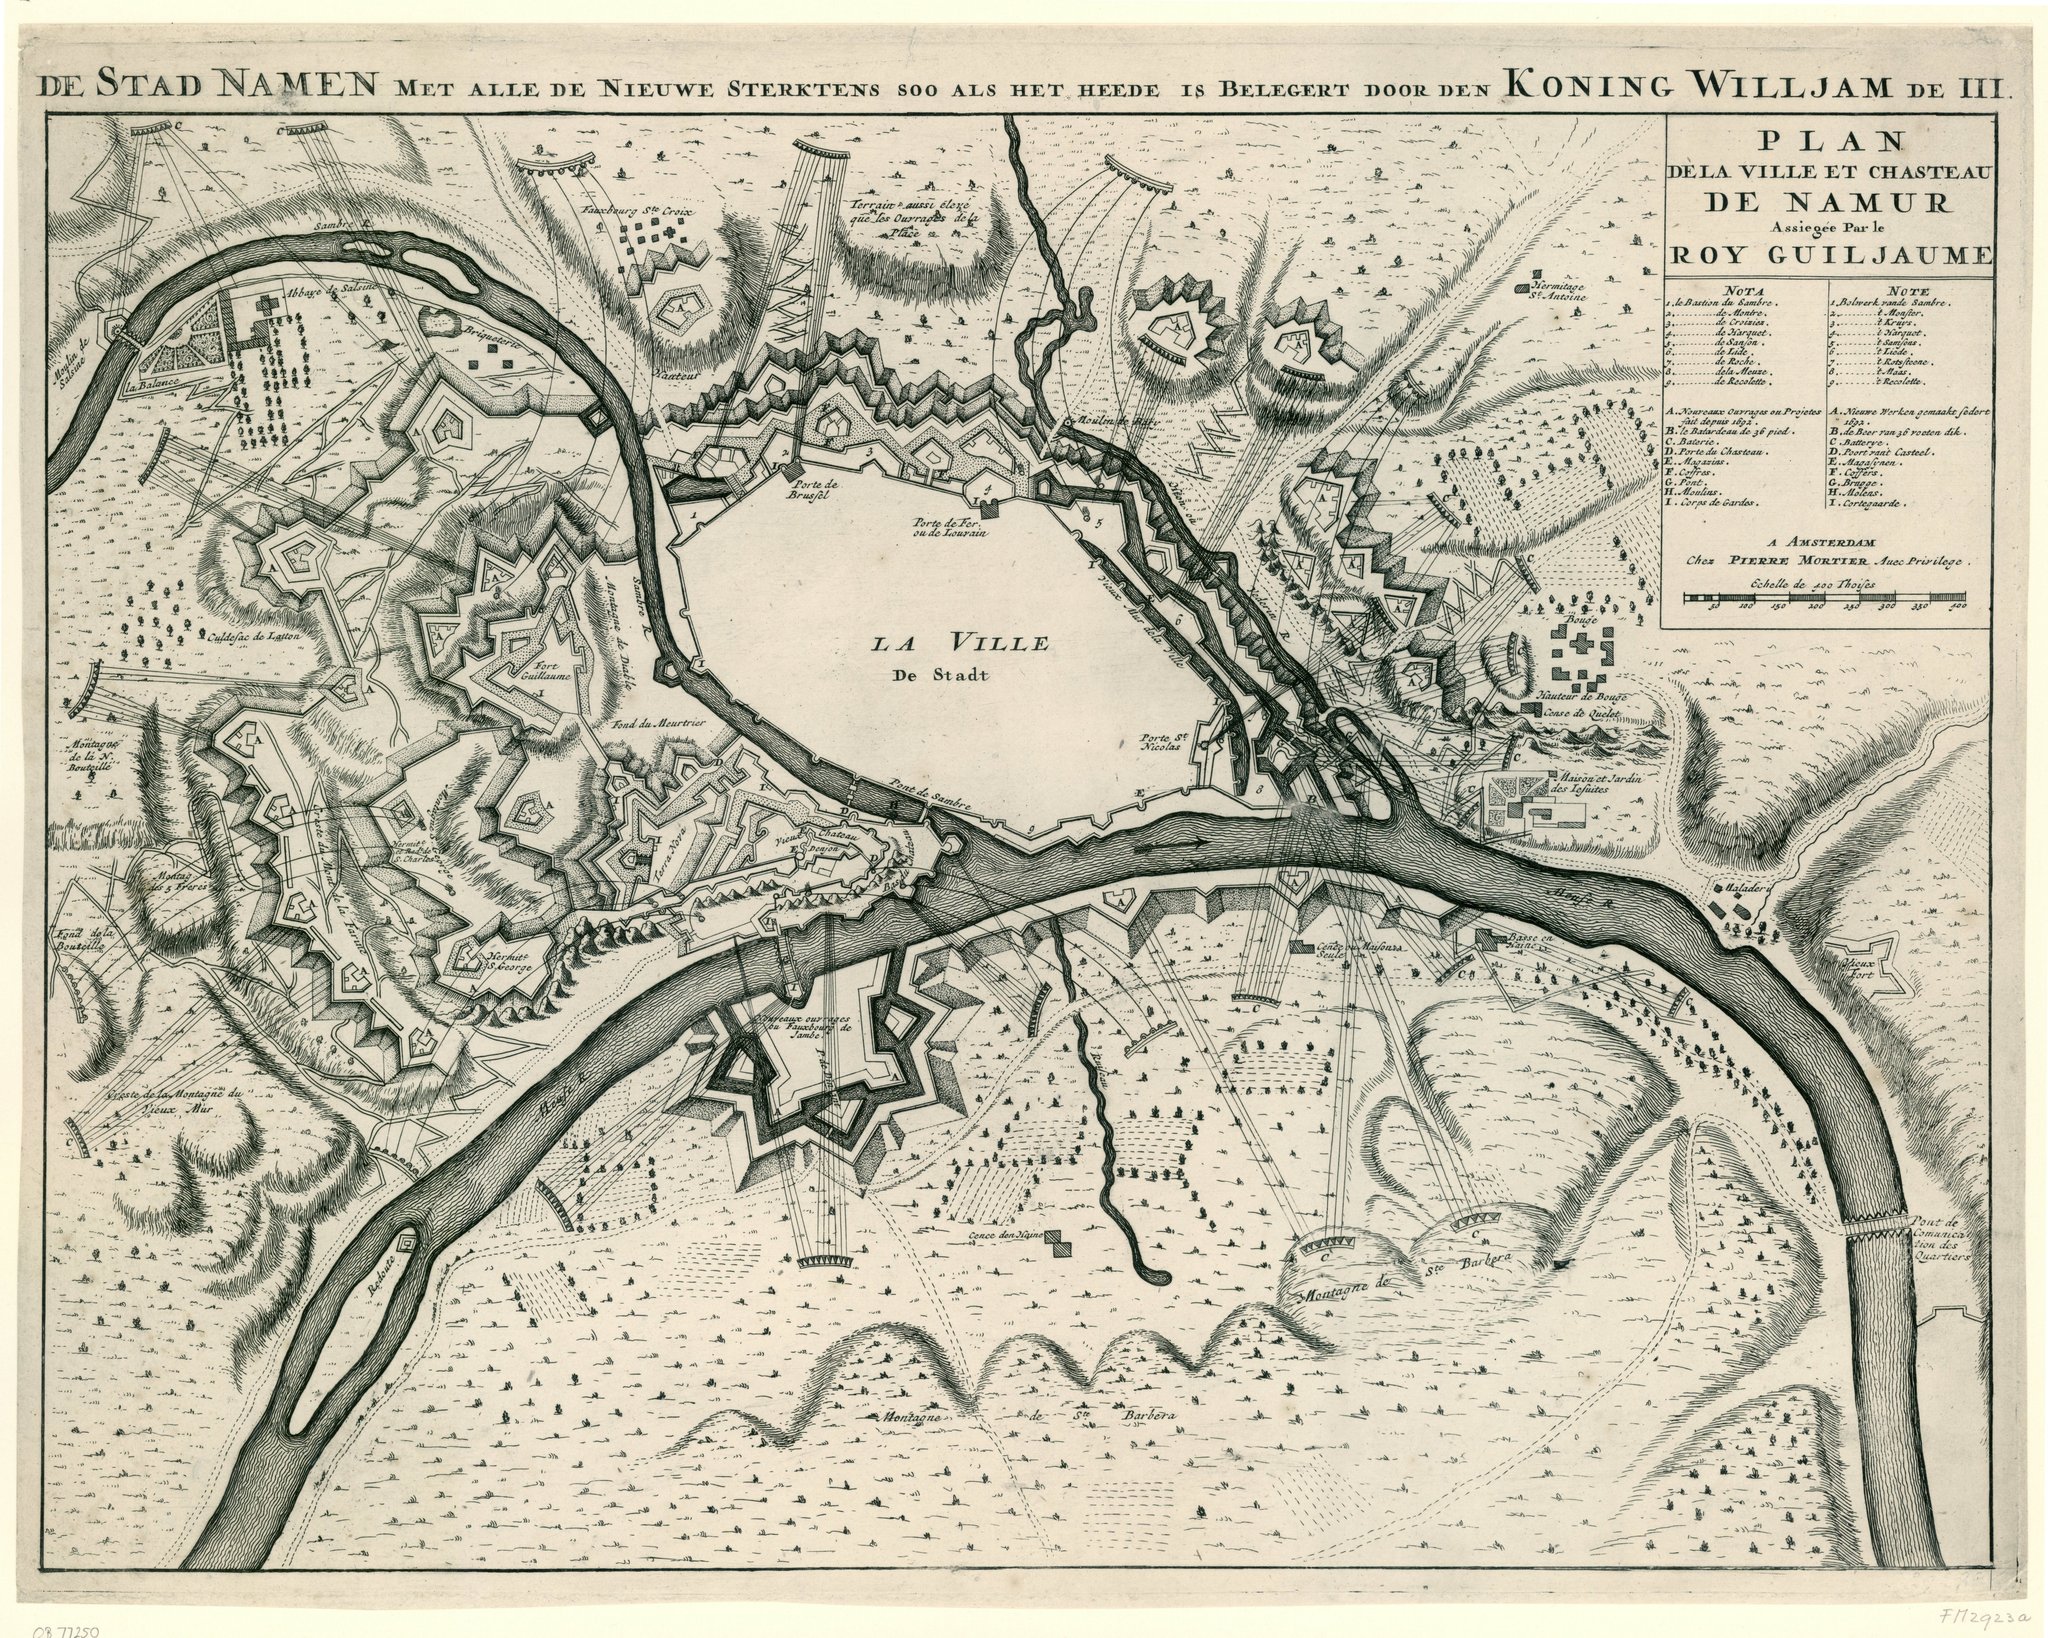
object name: print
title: Kaart van de versterkingen van Namen bij het beleg in 1695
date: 1695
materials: paper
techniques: etching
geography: northern netherlands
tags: the hague, william iii (prince of orange and king of england, scotland, and ireland), siege, position war, maps of cities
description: Plan van de stad Namen waarop de stellingen zijn aangegeven van waaruit de geallieerde troepen de stad belegerd en beschoten hebben vanaf 3 juli 1695. Rechtsboven een cartouche met een Franse titel en legenda's in het Frans en Nederlands.